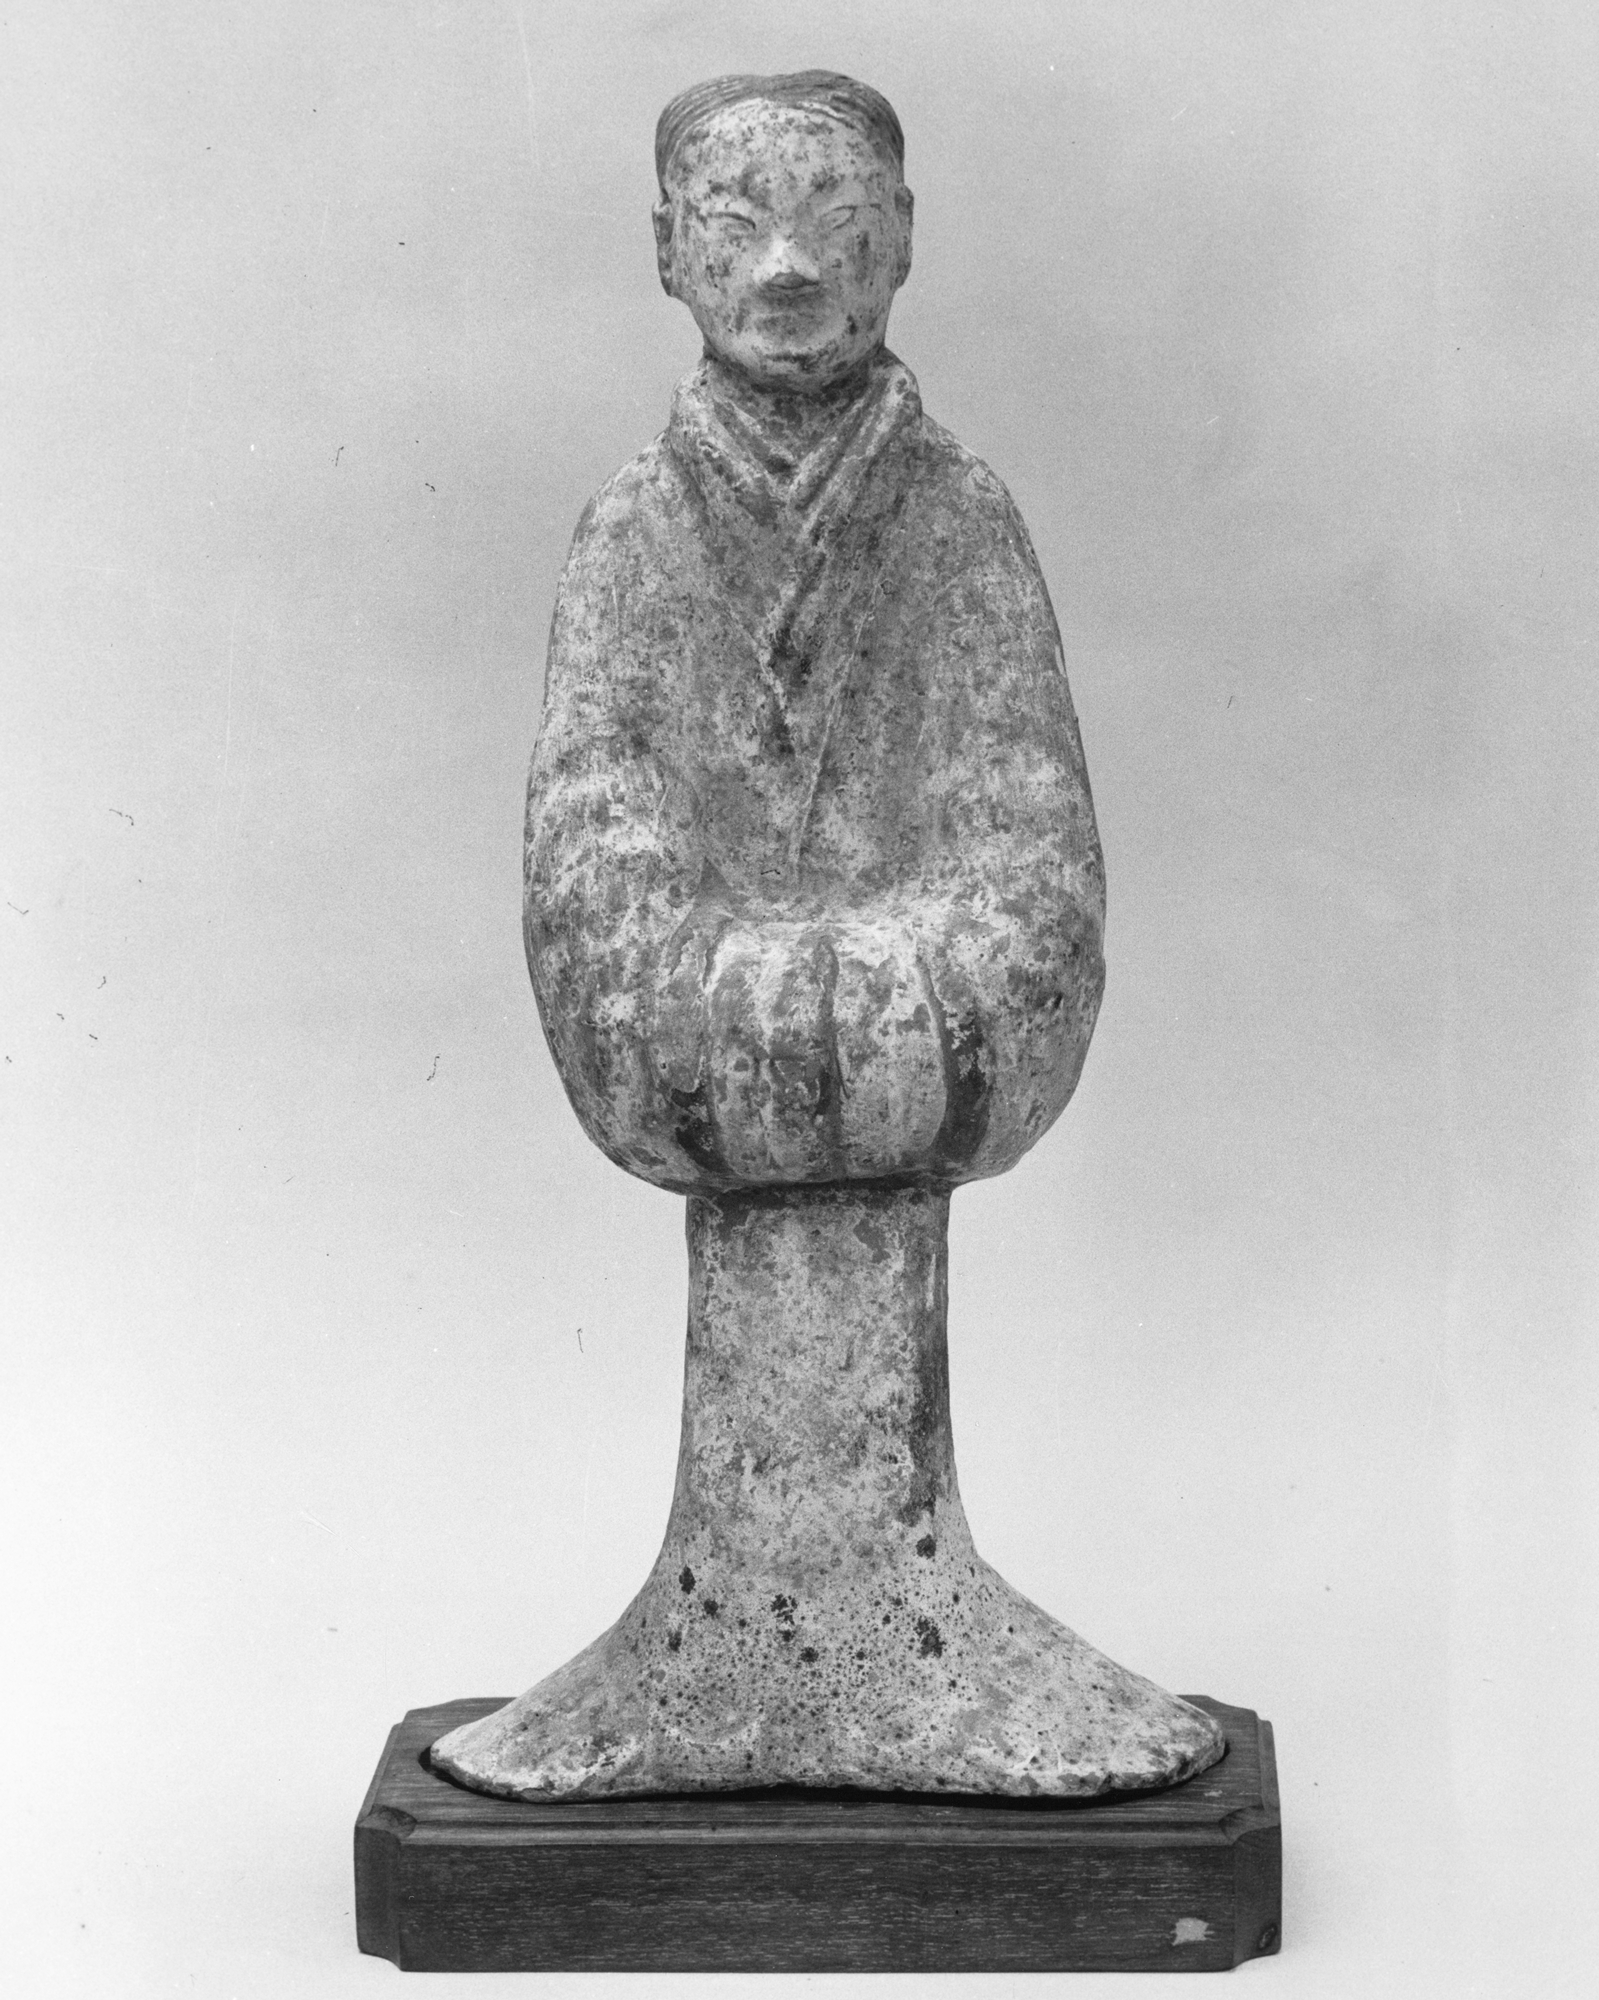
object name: figure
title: Figure of a Woman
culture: chinese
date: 25-220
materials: pottery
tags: women